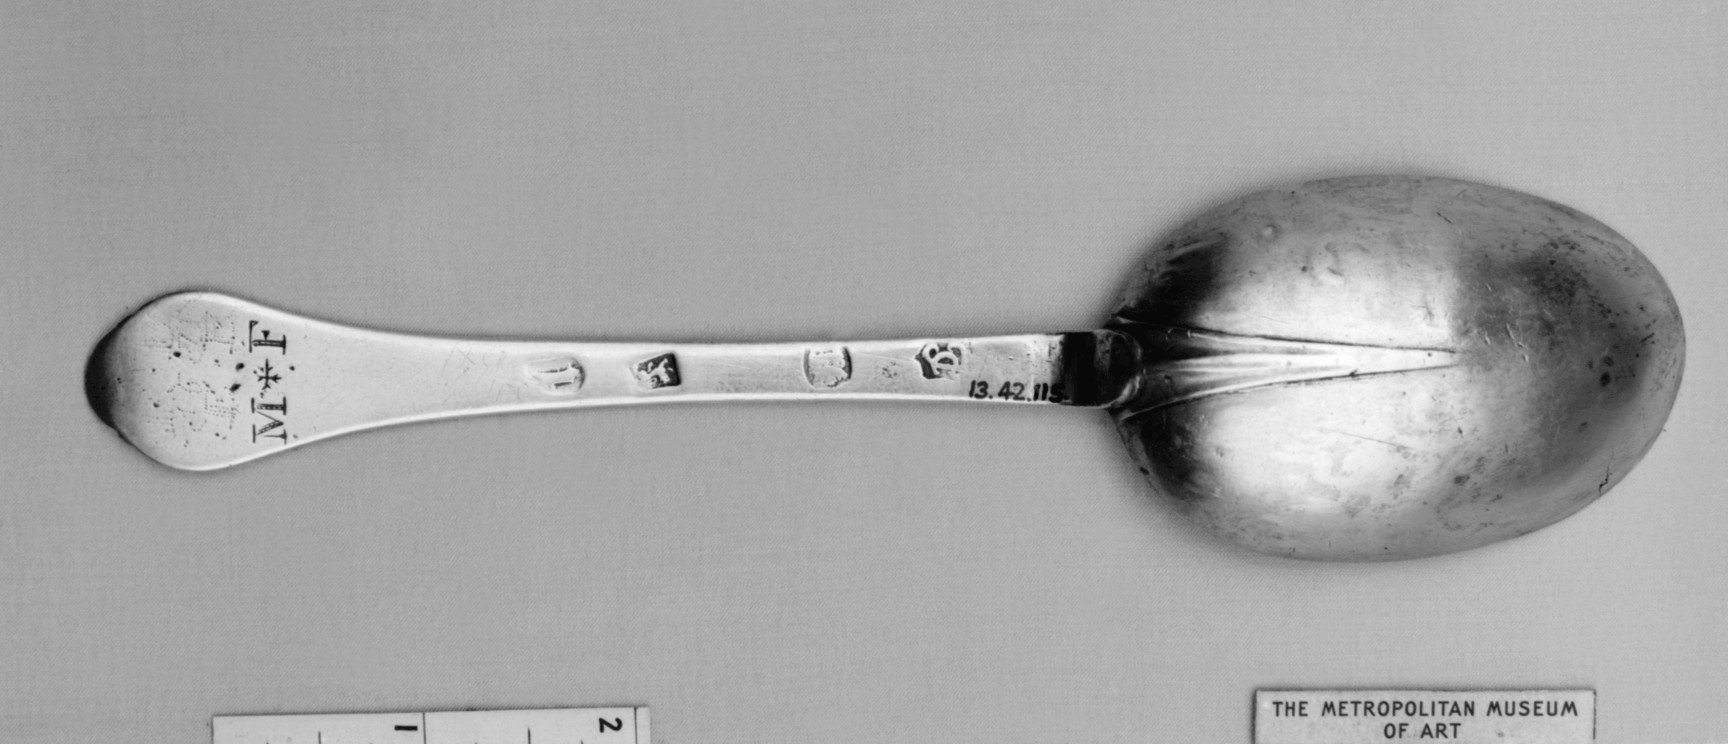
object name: spoon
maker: thomas cory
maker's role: maker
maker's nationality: british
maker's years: 1655-1689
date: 1688-1689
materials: silver